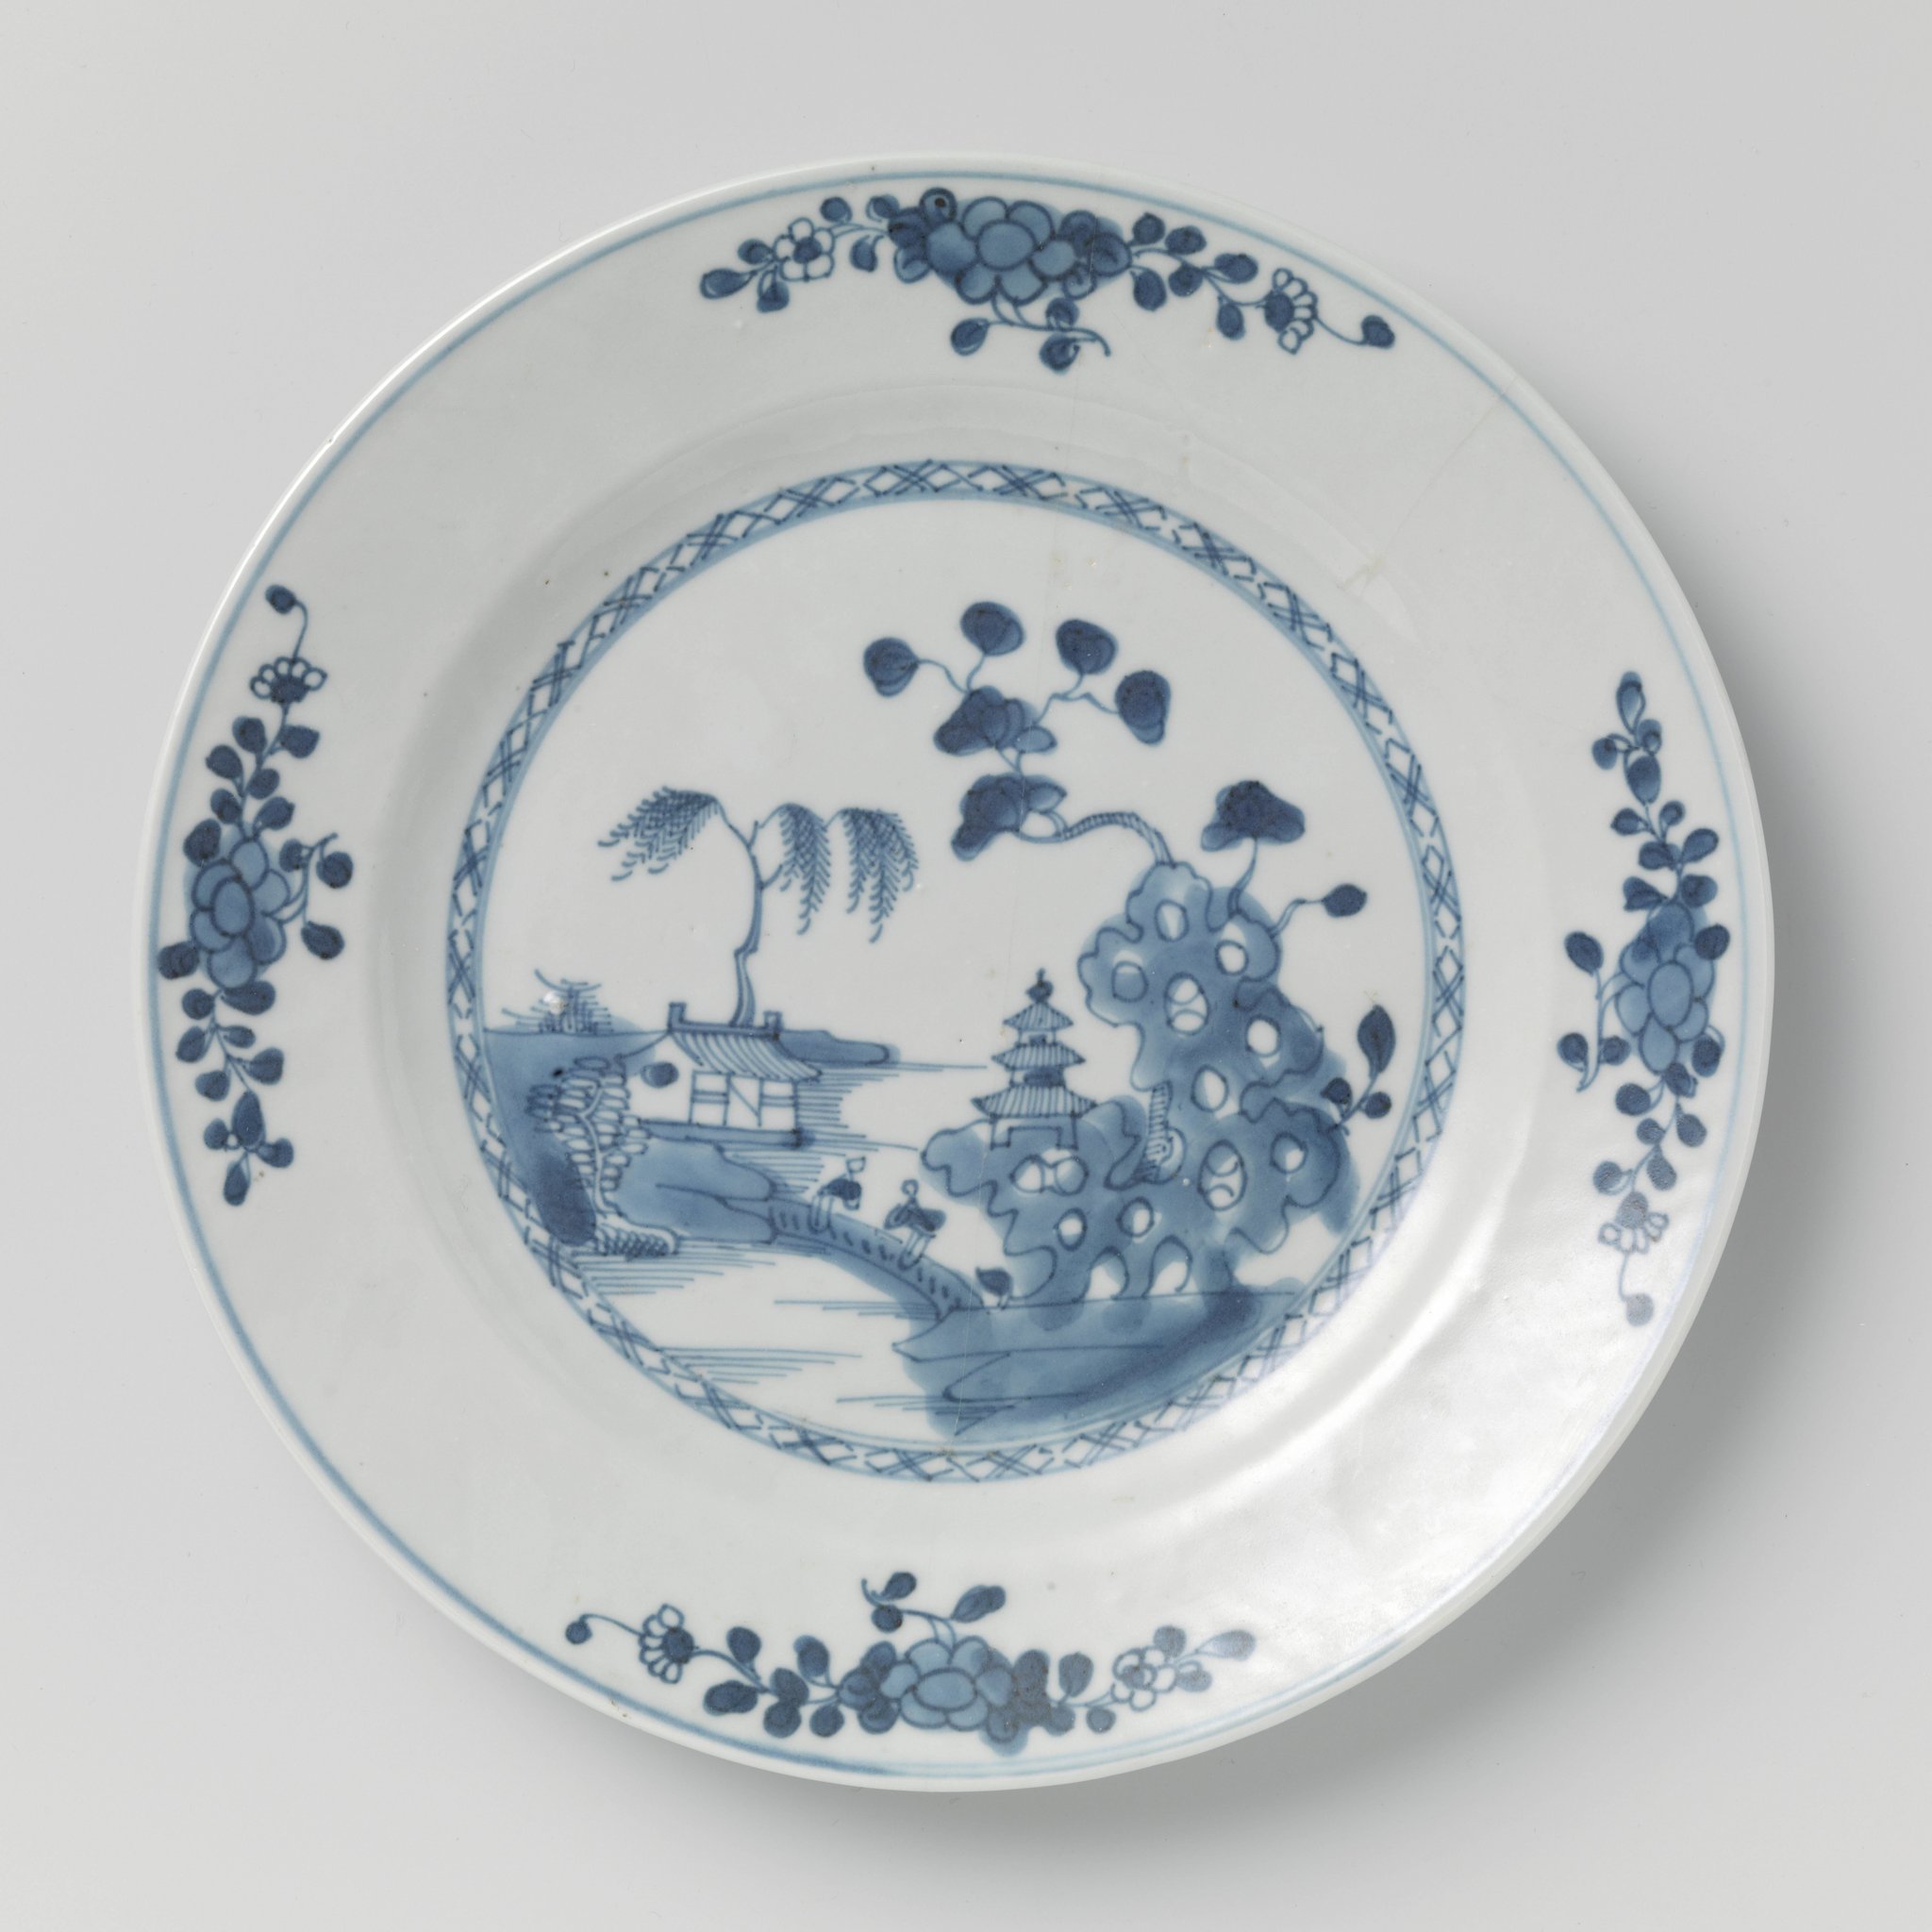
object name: plate dish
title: Plate with river landscape and flower sprays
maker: Anonymous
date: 1740-1760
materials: cobalt, glaze, paint, porcelain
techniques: firing, turning, vitrification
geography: china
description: Bord van porselein met ronde, korte wand en brede, schuine rand, beschilderd in onderglazuur blauw. Op het plat een rivierlandschap met twee personen op een brug, paviljoens, bomen en rotsen, hieromheen een band met geometrisch motief; op de rand vier keer een bloemtak. Bord is gebroken geweest. Blauw-wit.